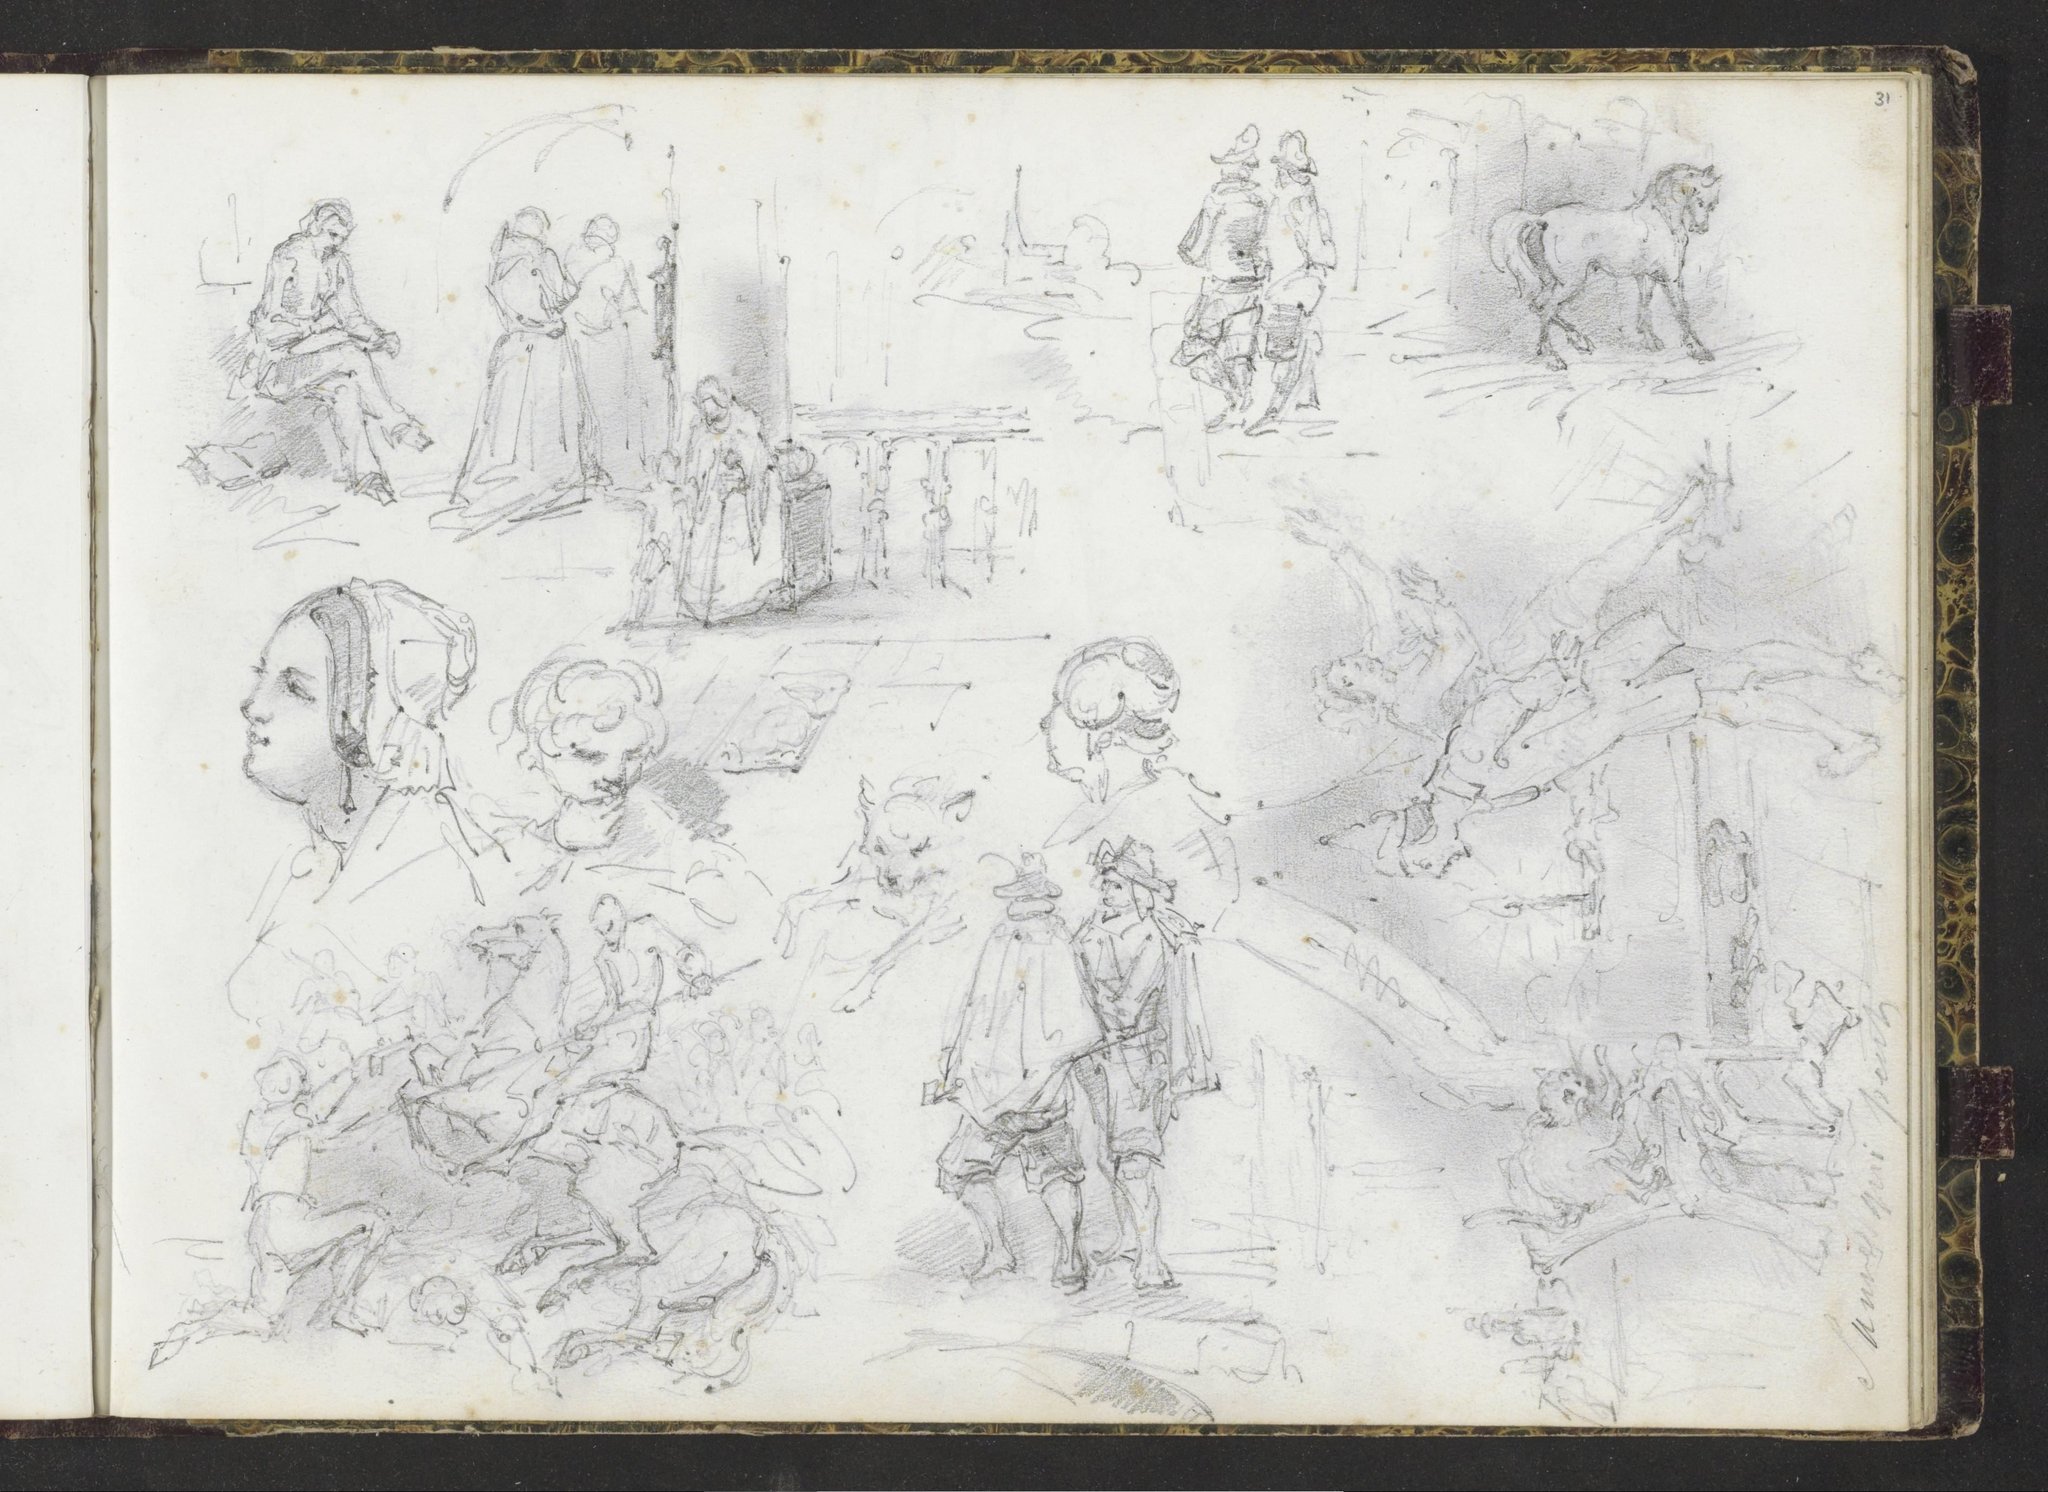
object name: sketchbook leaf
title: Studieblad met een gevecht, monniken en figuren in historisch kostuum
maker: lambertus lingeman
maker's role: draughtsman, painter, print maker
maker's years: 1829-1894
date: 1839-1894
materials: paper, pencil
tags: battle, monk(s), friar(s), historical costume, horse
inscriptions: annotation: ‘sauvé qui peut’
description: Tevens een studie van een man in nachtkleding met een kaars in de hand die een kat betrapt in zijn slaapkamer. De kat zit op een stoel en krabt aan de kleding die op de stoel ligt. Achter de man sprint een vrouw de kamer uit. Blad 31 recto uit een schetsboek met 51 bladen.